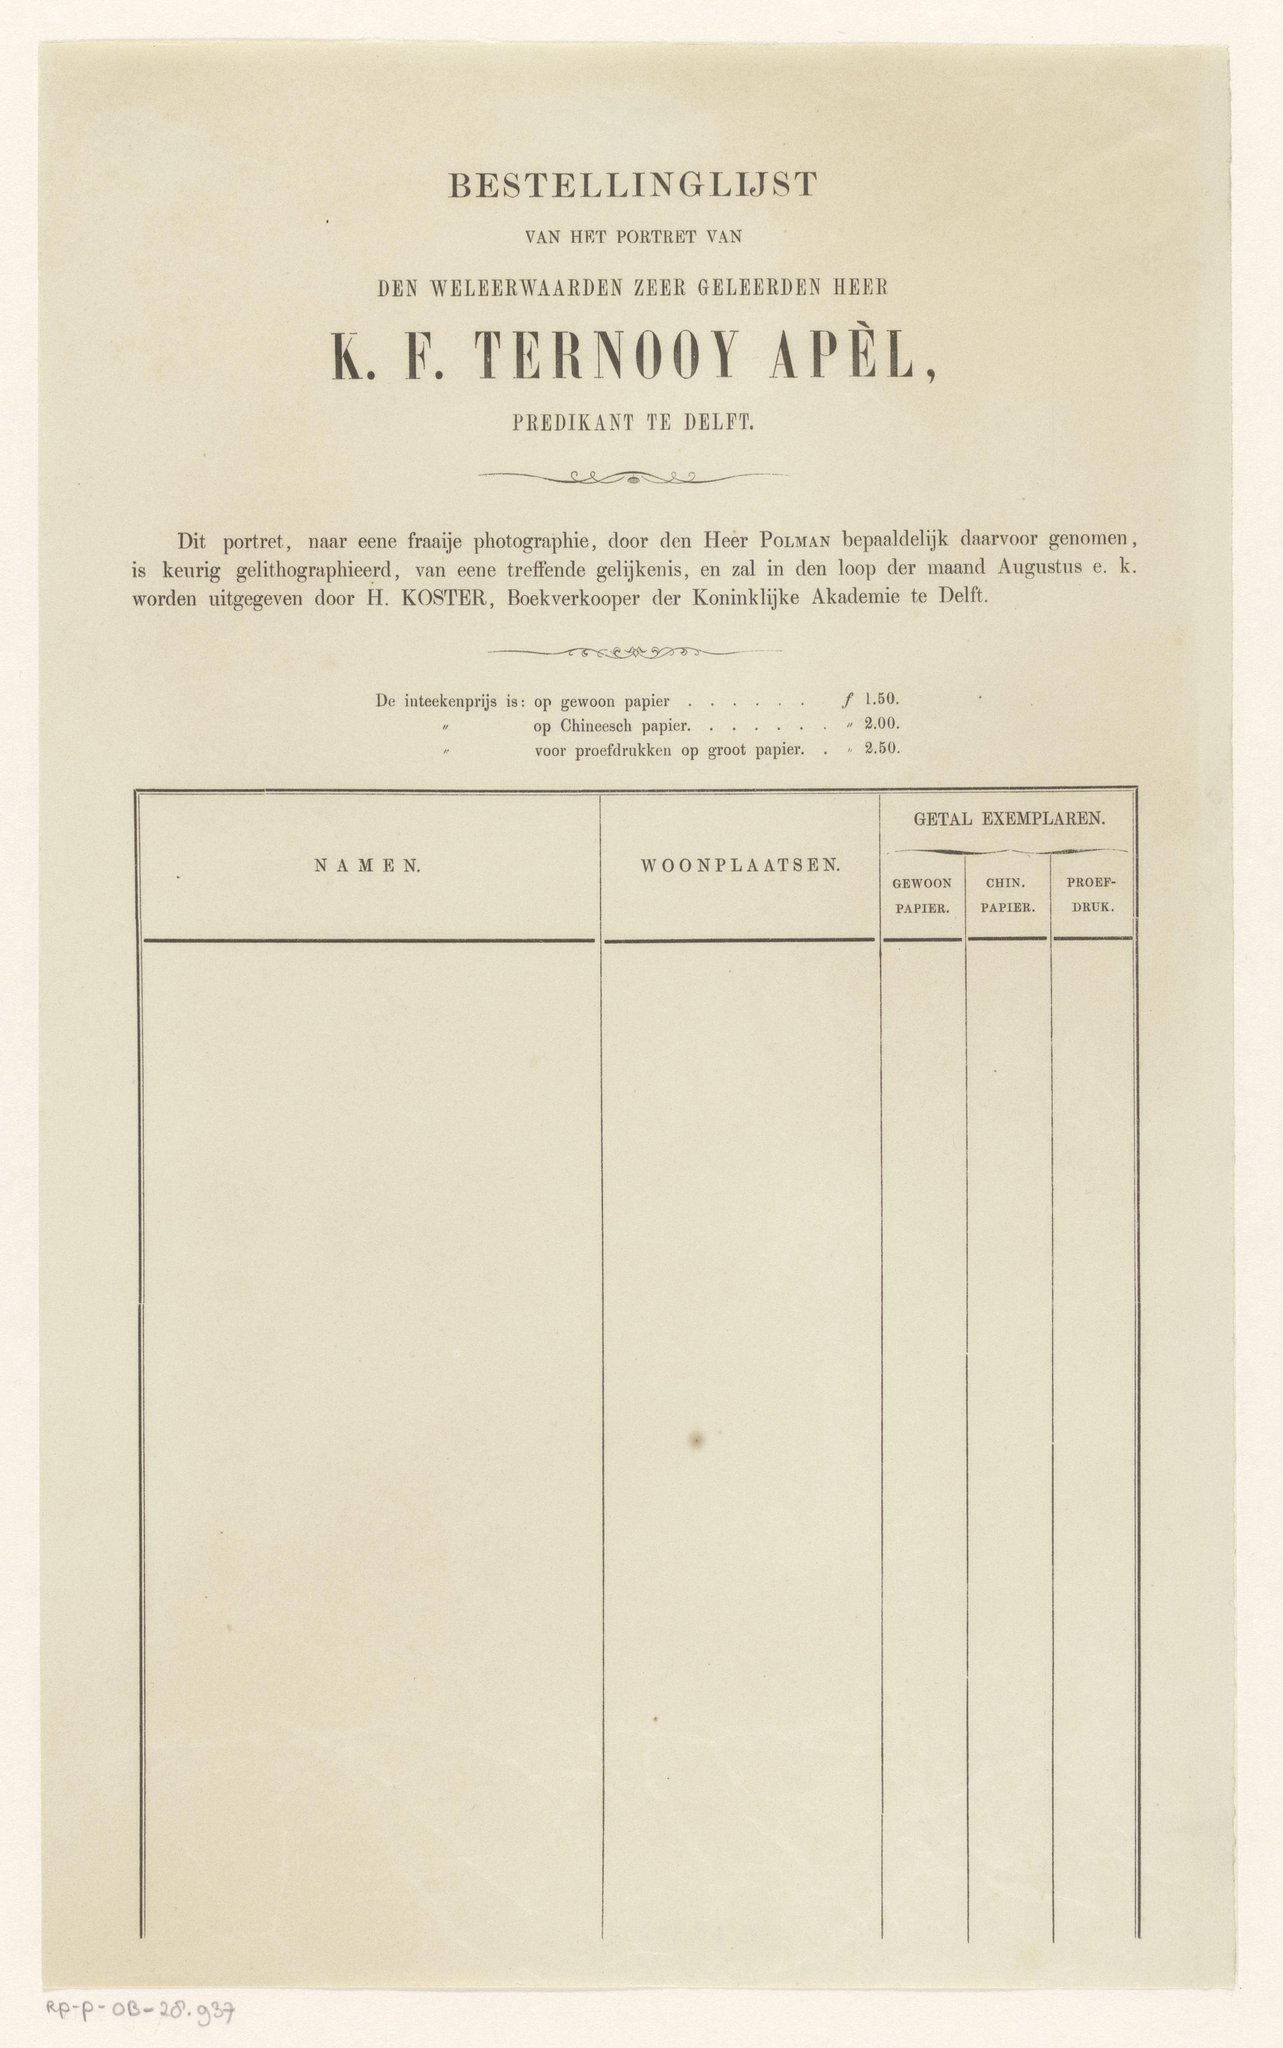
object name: print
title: Bestellinglijst van het portret van Karel Frederik Ternooy Apel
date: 1845-1907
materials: paper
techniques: lithograph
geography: delft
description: De intekenlijst behoort tot een portret van Karel Frederik Ternooy Apel door Willem Bernardus IJzerdraat, naar een foto van Anthony Martinus Hayo Polman.